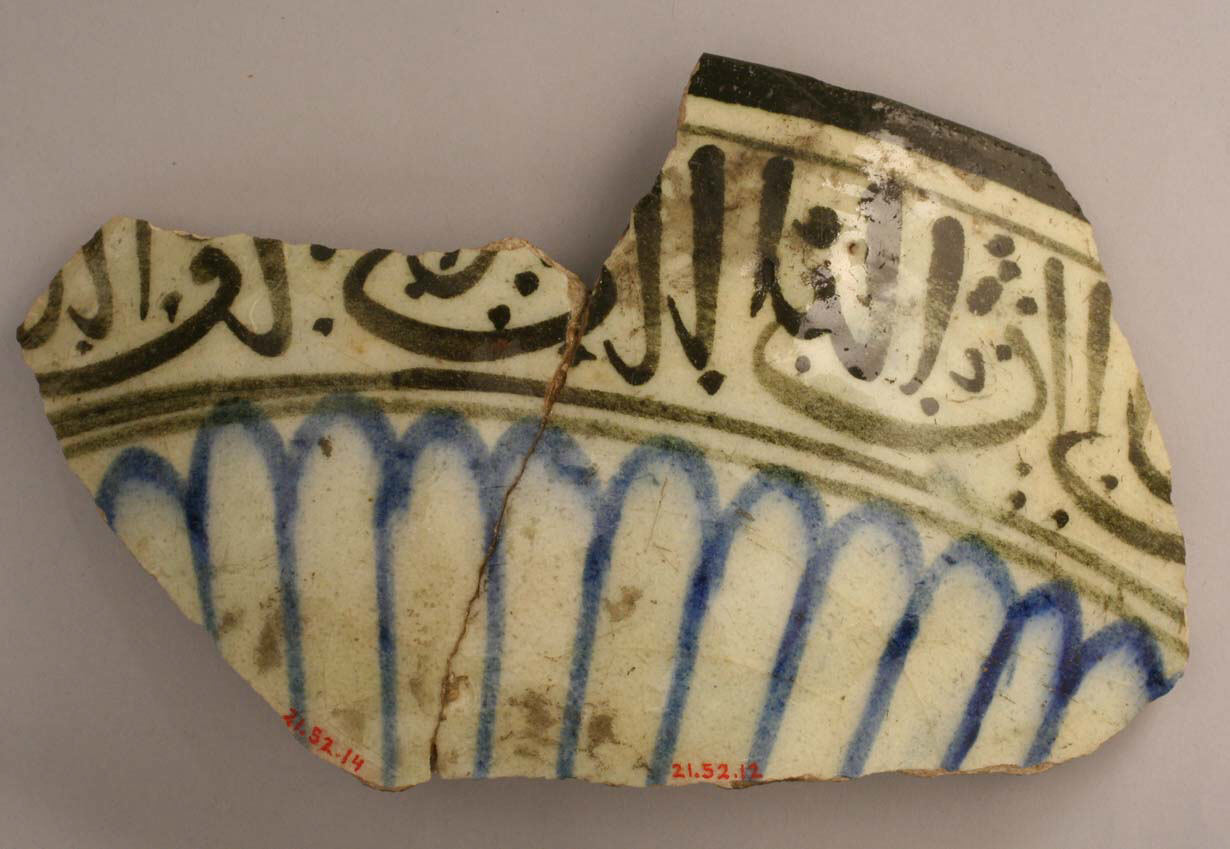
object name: fragment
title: Ceramic Fragment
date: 1301-1400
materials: stonepaste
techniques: painting, underglaze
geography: egypt